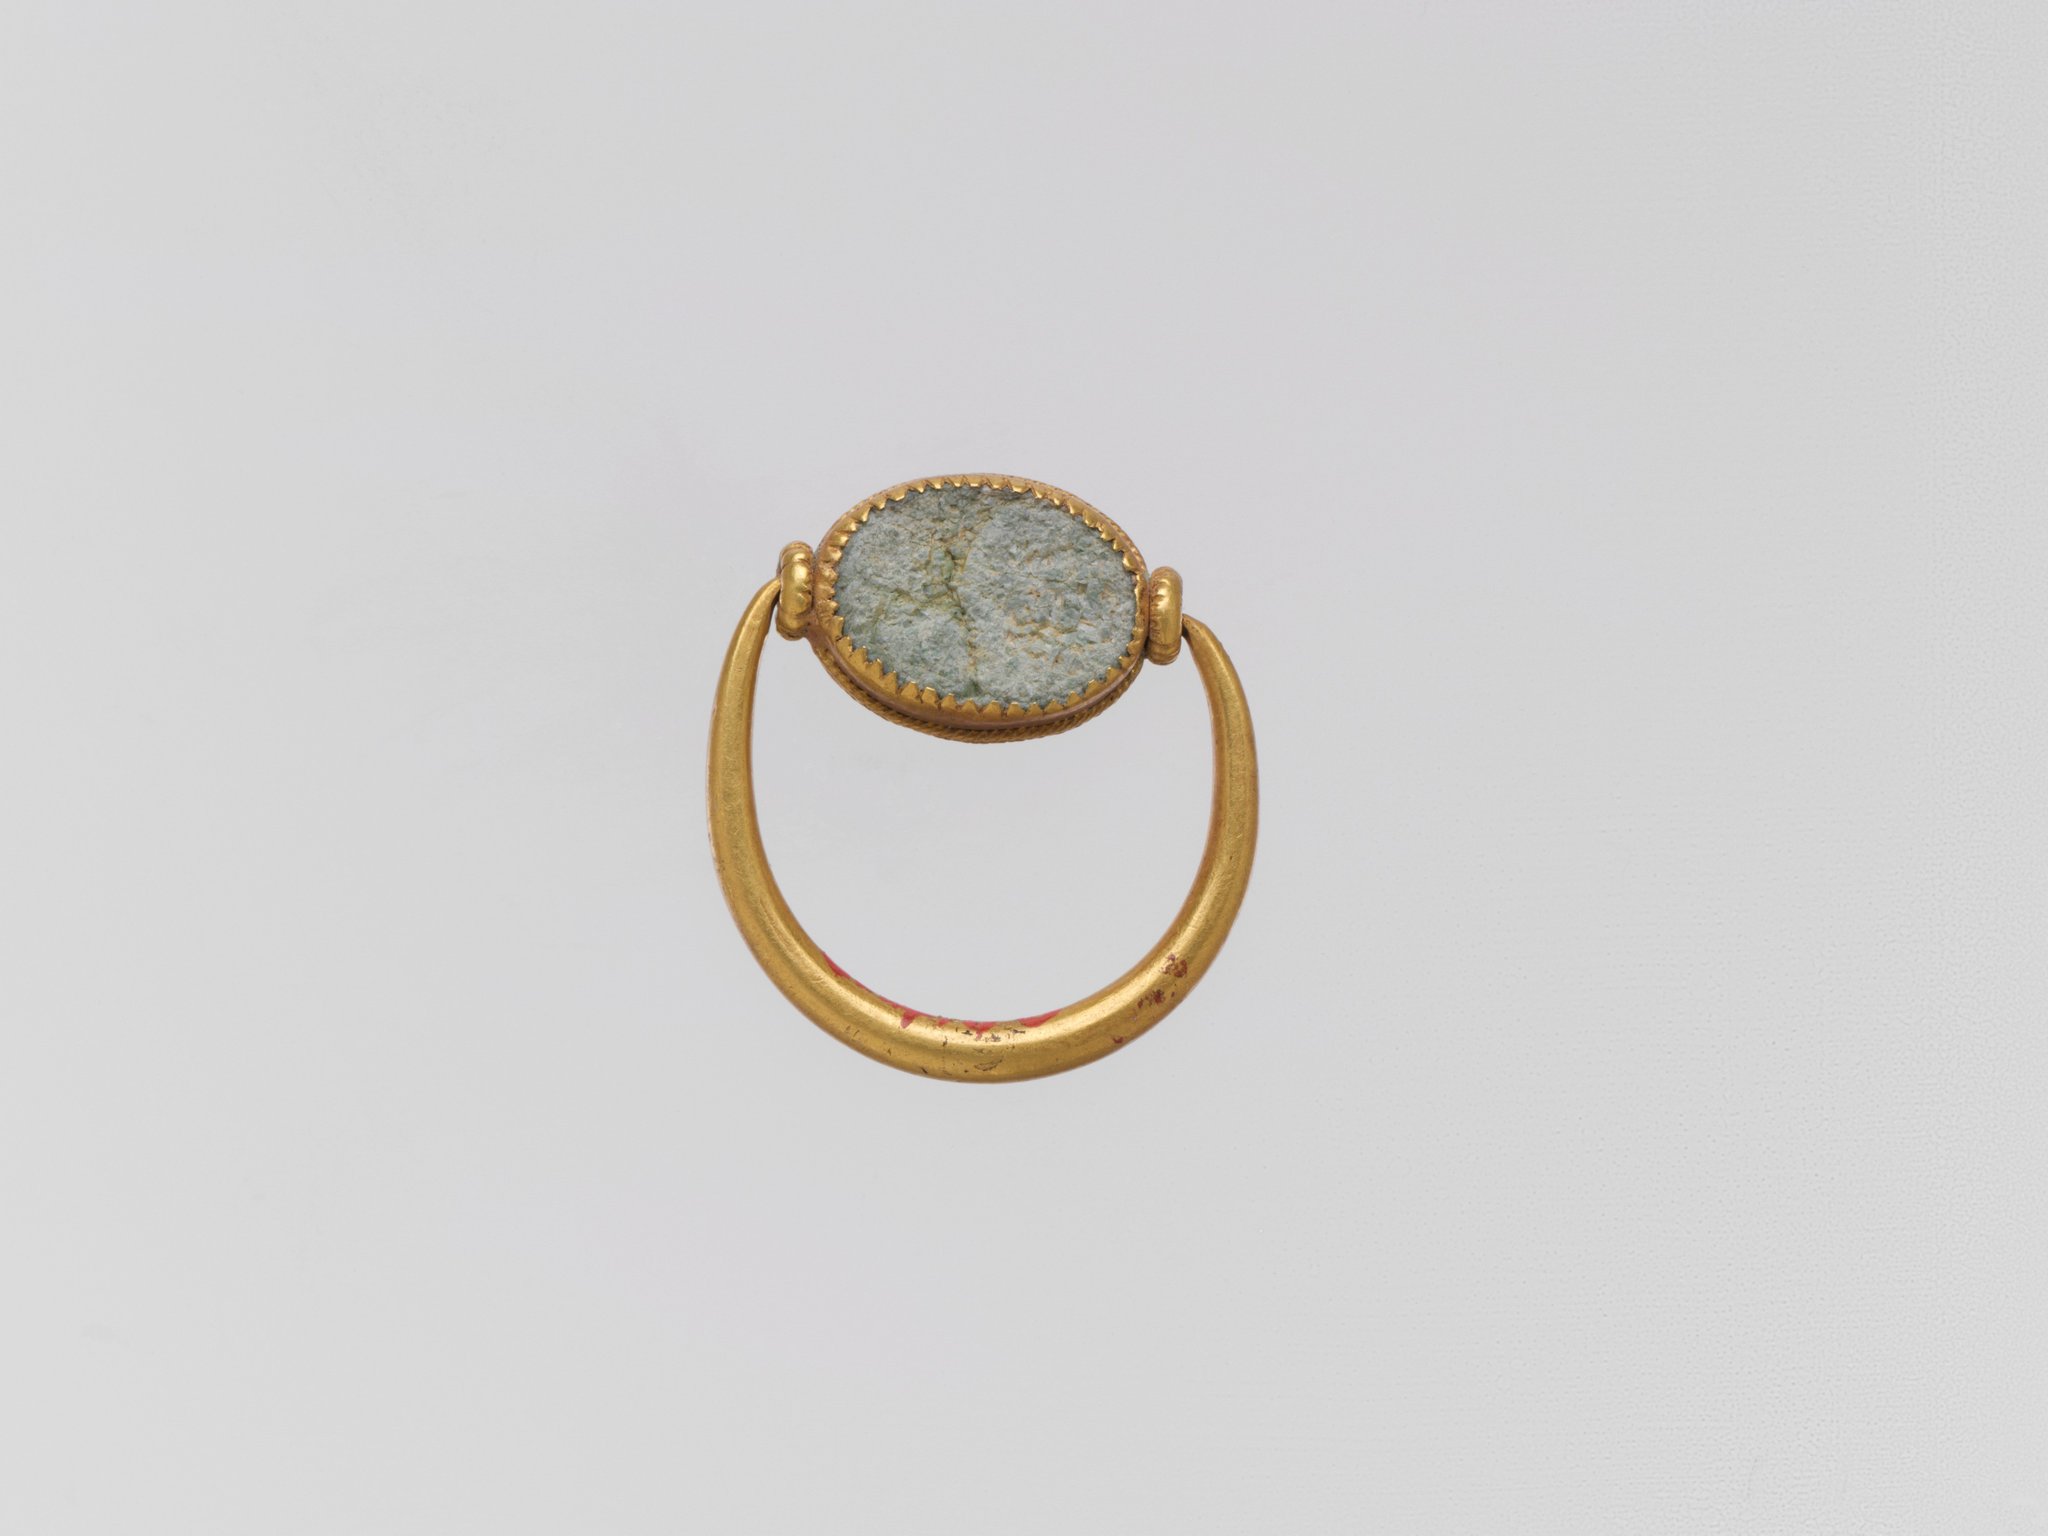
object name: ring with glass paste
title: Gold ring with glass paste ring stone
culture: cypriot or greek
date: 600-401 BCE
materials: glass, gold, paste